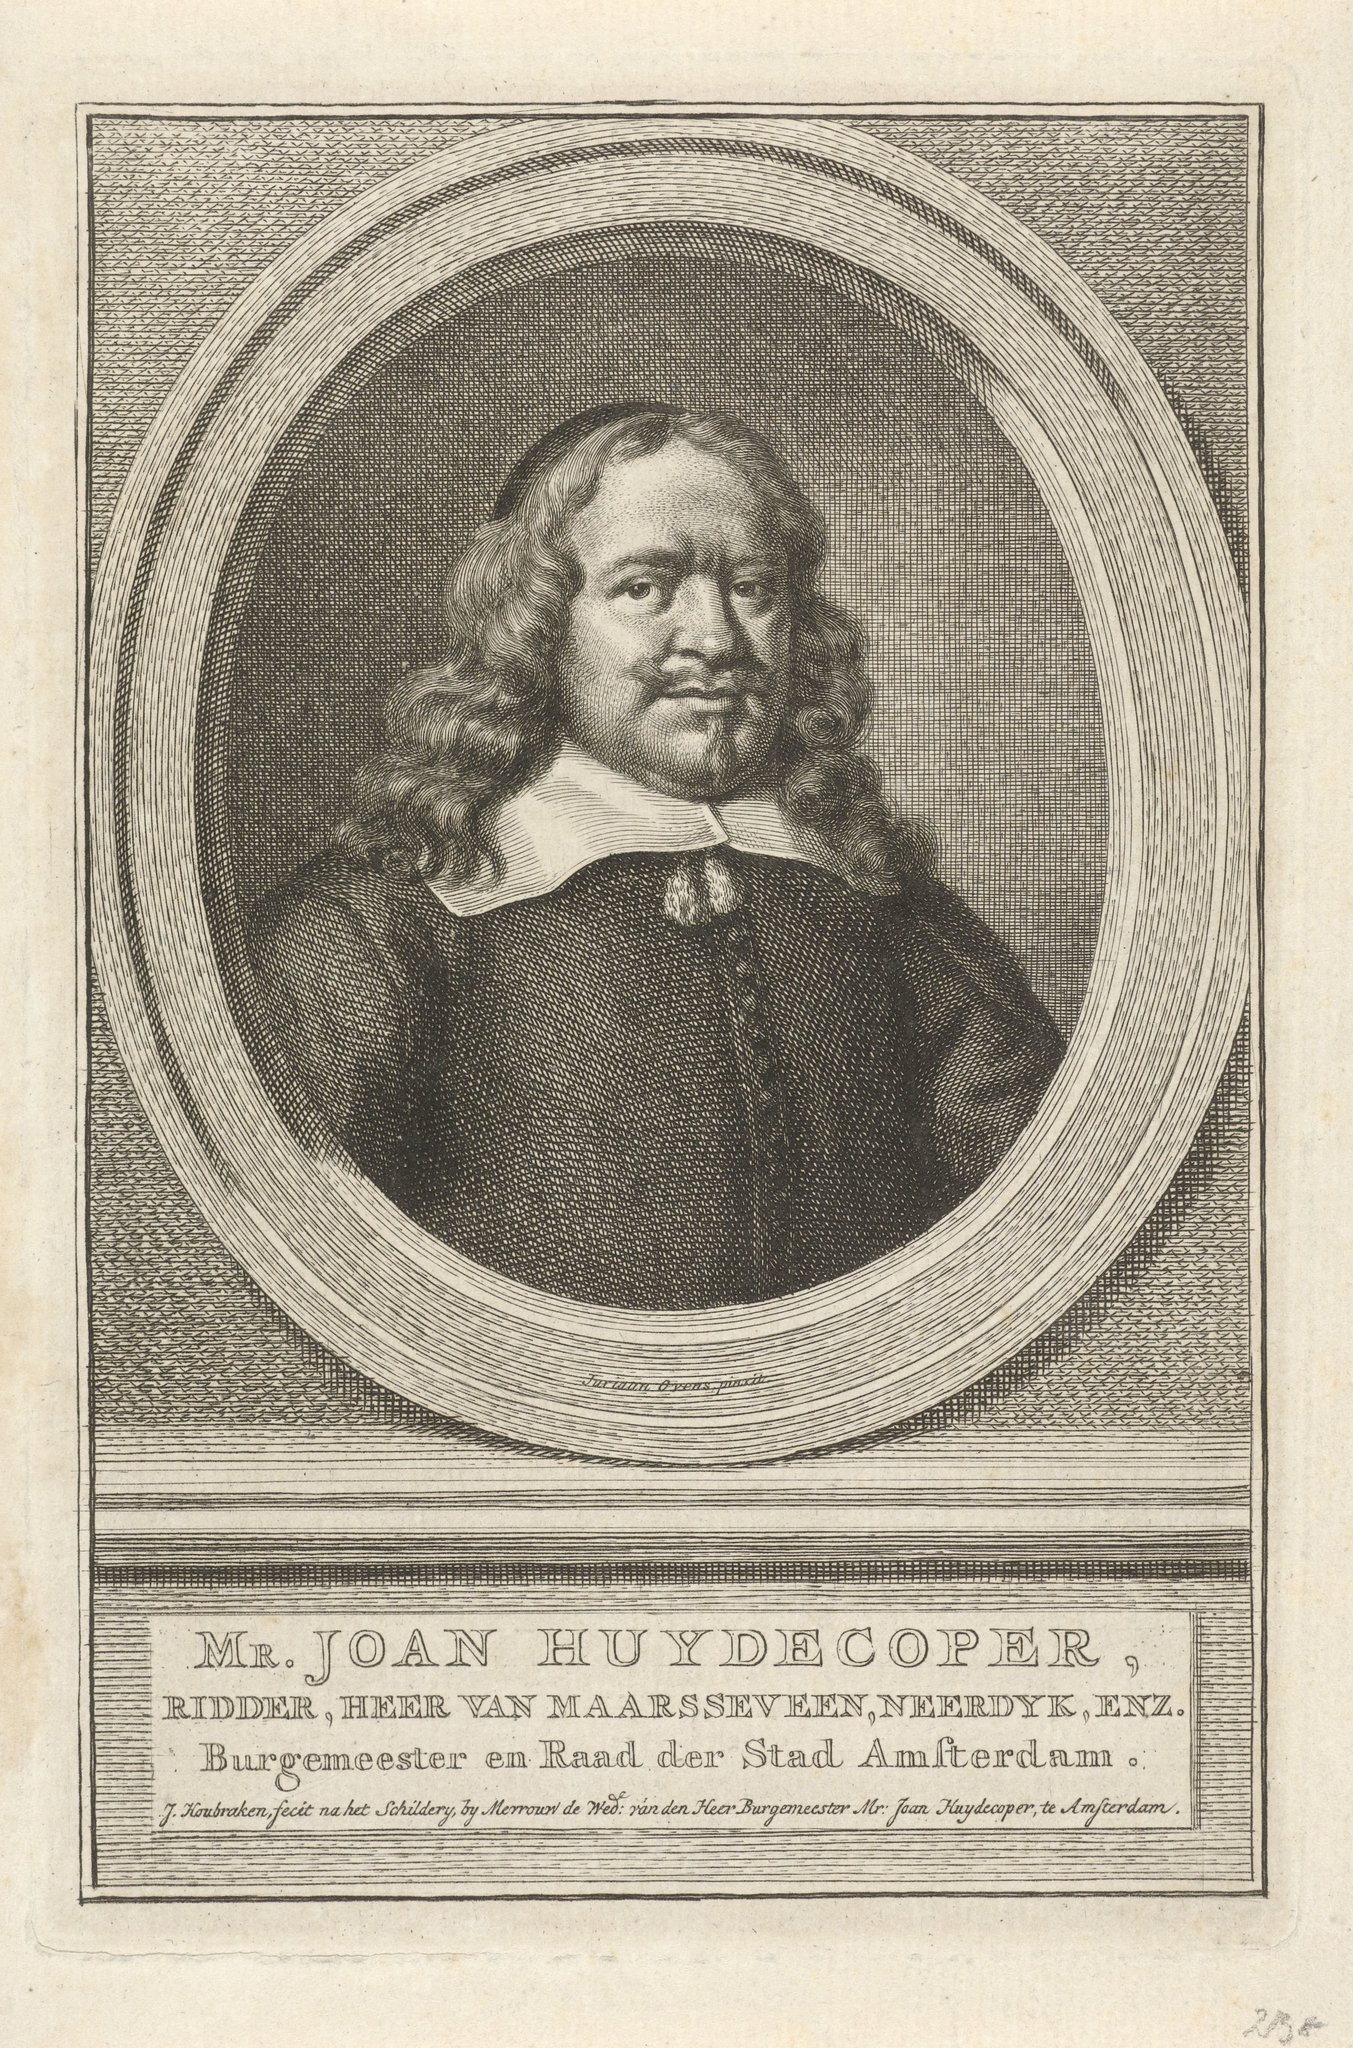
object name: print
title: Portret van ridder Joan Huydecoper II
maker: jacob houbraken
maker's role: draughtsman, print maker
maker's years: 1698-1780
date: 1749-1780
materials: paper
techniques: engraving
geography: amsterdam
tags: mayor, joan huydecoper van maarsseveen (ii), historical persons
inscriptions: collector's mark: Lugt 2228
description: Deze prent is oorspronkelijk bedoeld als aanvulling op Jan Wagenaars ‘Vaderlandsche historie’* en was zo vanaf 1796 verkrijgbaar bij Johannes Allart te Amsterdam. Voor de advertentie waarin Allart de 60 portretten en 7 platen, allen gegraveerd door Houbraken, ter aanvulling op Wagenaars ‘Vaderlandsche historie’ aanbiedt, zie RP-P-OB-77.766. *Van dit werk zijn in de achttiende eeuw meerdere uitgaves verschenen, zoals: Wagenaar, Jan. Vaderlandsche historie, vervattende de geschiedenissen der Vereenigde Nederlanden (…). 21 delen. Amsterdam: Isaak Tirion, 1749-1759. Wagenaar, Jan. Vaderlandsche historie, vervattende de geschiedenissen der nu Vereenigde Nederlanden (…). 21 delen. Amsterdam: weduwe Isaak Tirion, 1770. Wagenaar, Jan. Vaderlandsche historie, vervattende de geschiedenissen der nu Vereenigde Nederlanden (…). 21 delen. Amsterdam, Leiden, Dordrecht en Harlingen: P. Schouten e.a., 1782. Wagenaar, Jan. Vaderlandsche historie, vervattende de geschiedenissen der nu Vereenigde Nederlanden (…). 21 delen. Amsterdam: Johannes Allart, 1790-1796.